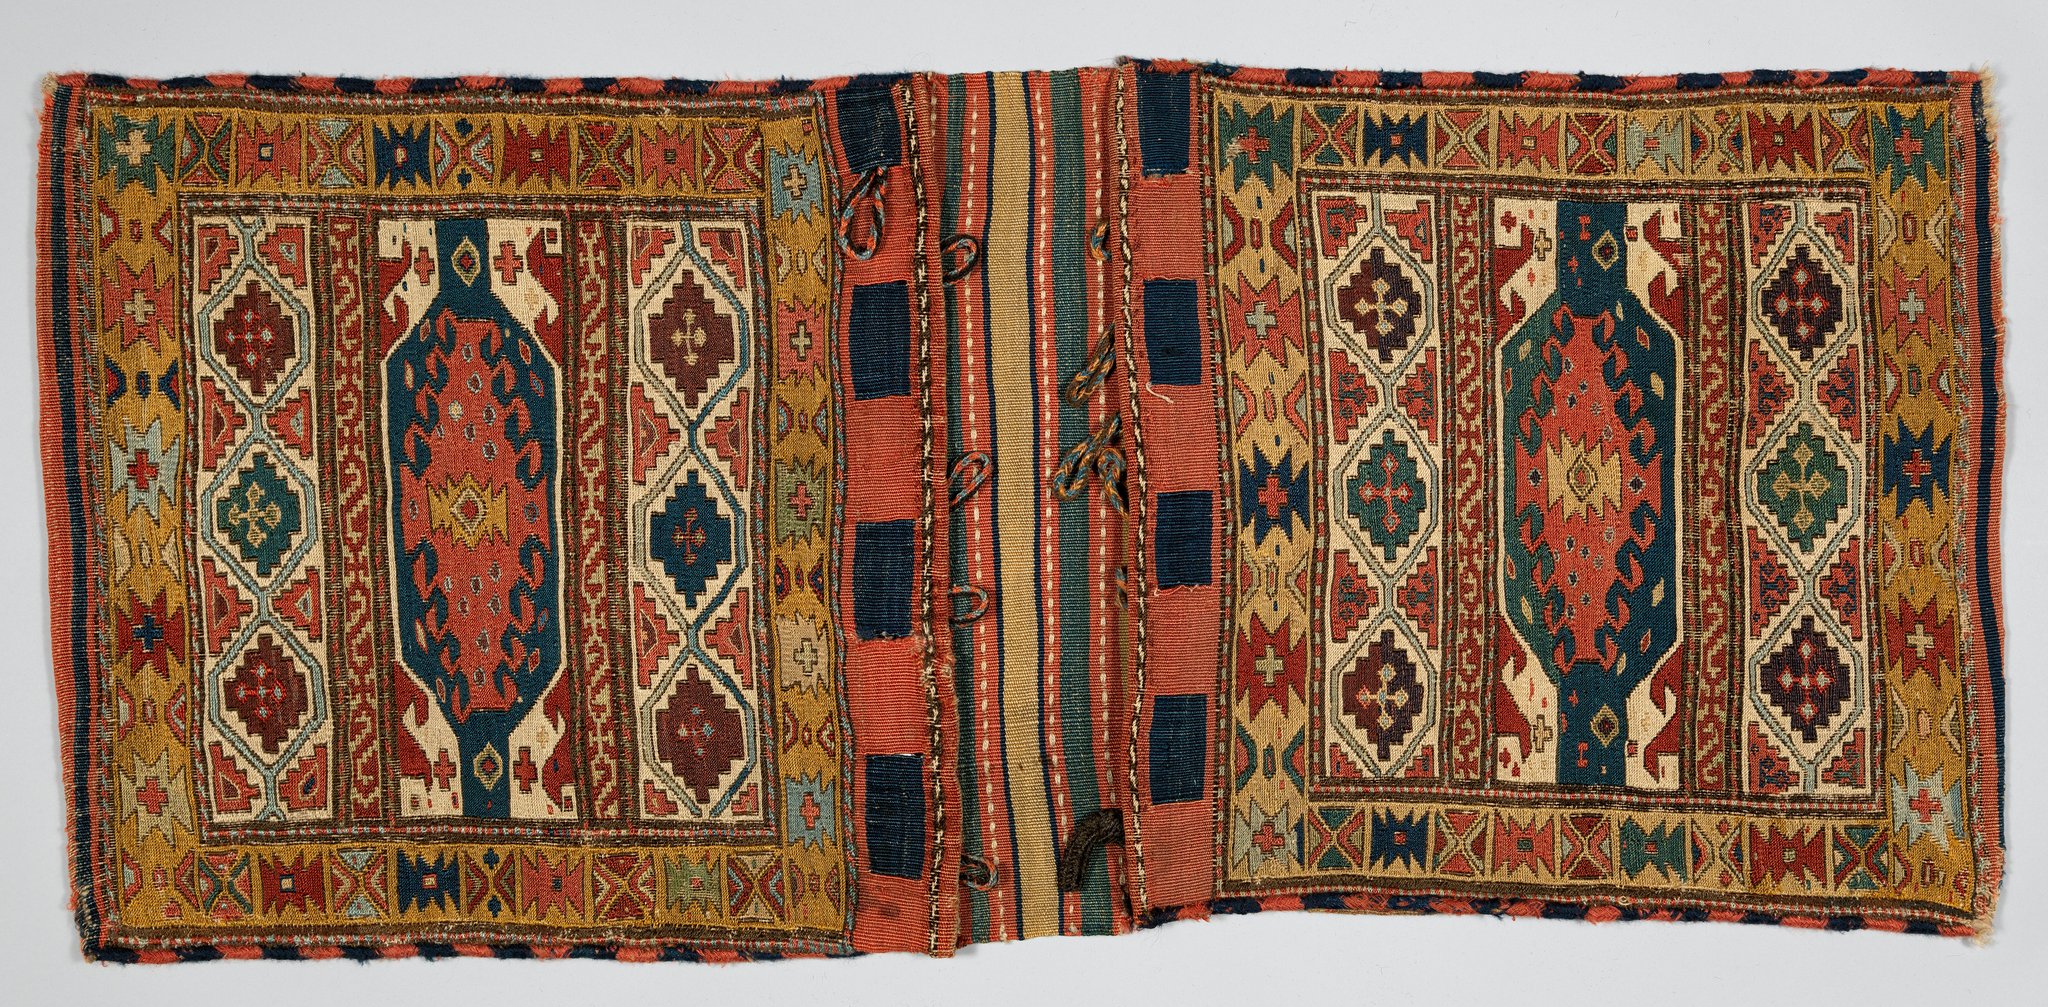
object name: saddle bag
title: Double Saddle Bag (Khorjin)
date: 1800-1825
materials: hair, wool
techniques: weave, slit, tapestry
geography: iran